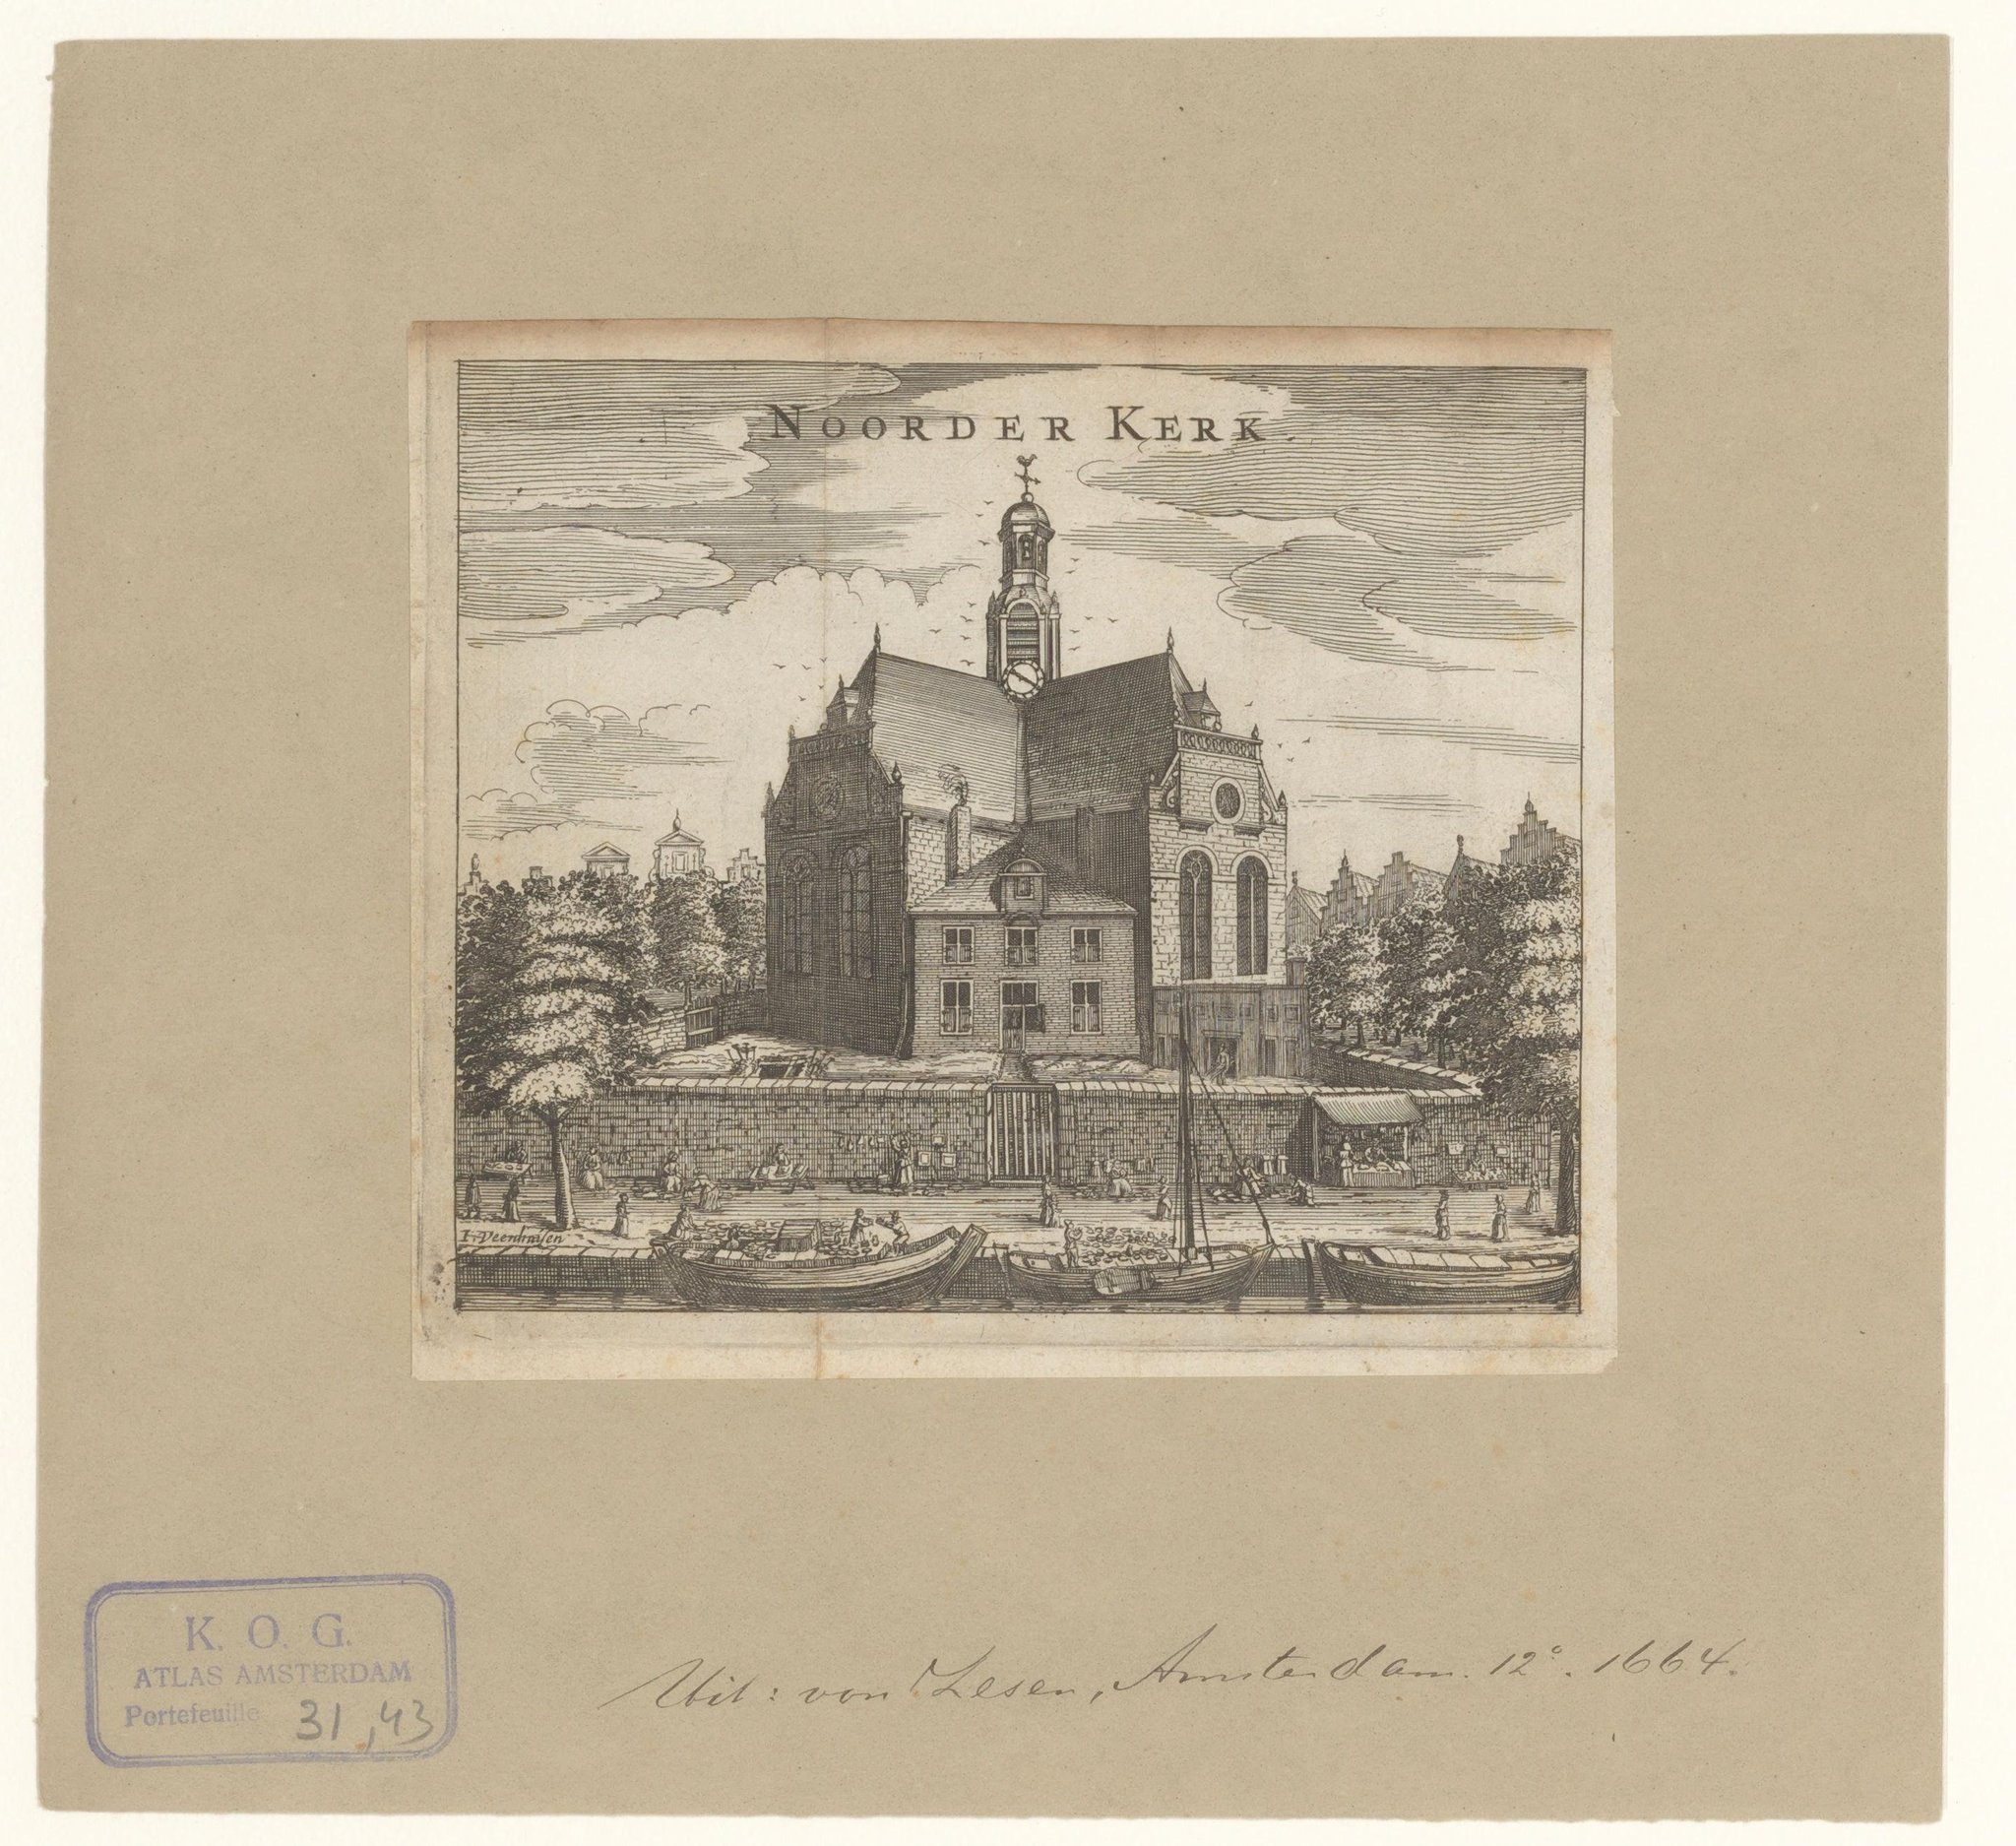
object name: print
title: Noorder Kerk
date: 1664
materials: paper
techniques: engraving, etching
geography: amsterdam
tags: ships (in general), church (exterior), market, canals, waters (in city) (+ city(-scape) with figures, staffage)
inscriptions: collector's mark: Lugt 1641b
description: Huidige staat van prent ook gebruikt in: Fockens, Melchior. Beschrijvingh Der wijdt-vermaarde Koop-stadt Amstelredam (…). 3de druk. Amsterdam: Marcus Willemsz. Doornick, 1664. En in: Zesen, Philipp von. Beschreibung der Stadt Amsterdam (…). Amsterdam: Marcus Wilhelm Doornick, 1664. Eerste bekende staat (rechtsboven genummerd: 226) ook gebruikt in: Fockens, Melchior. Beschrijvinge Der wijdt-vermaarde Koop-stadt Amstelredam (…). 2de druk. Amsterdam: Marcus Willemsz. Doornick, 1662. Derde bekende staat (met toevoeging Franse titel) ook gebruikt in: Domselaer, Tobias en Isaac Commelin. Beschryvinge van Amsterdam (…). 6 dln. Amsterdam: Marcus Willemsz. Doornick, 1665, dl. 4, p. 82. Vierde bekende staat (rechtsboven genummerd: 14) ook gebruikt in verschillende latere zeventiende- en achttiende-eeuwse publicaties.